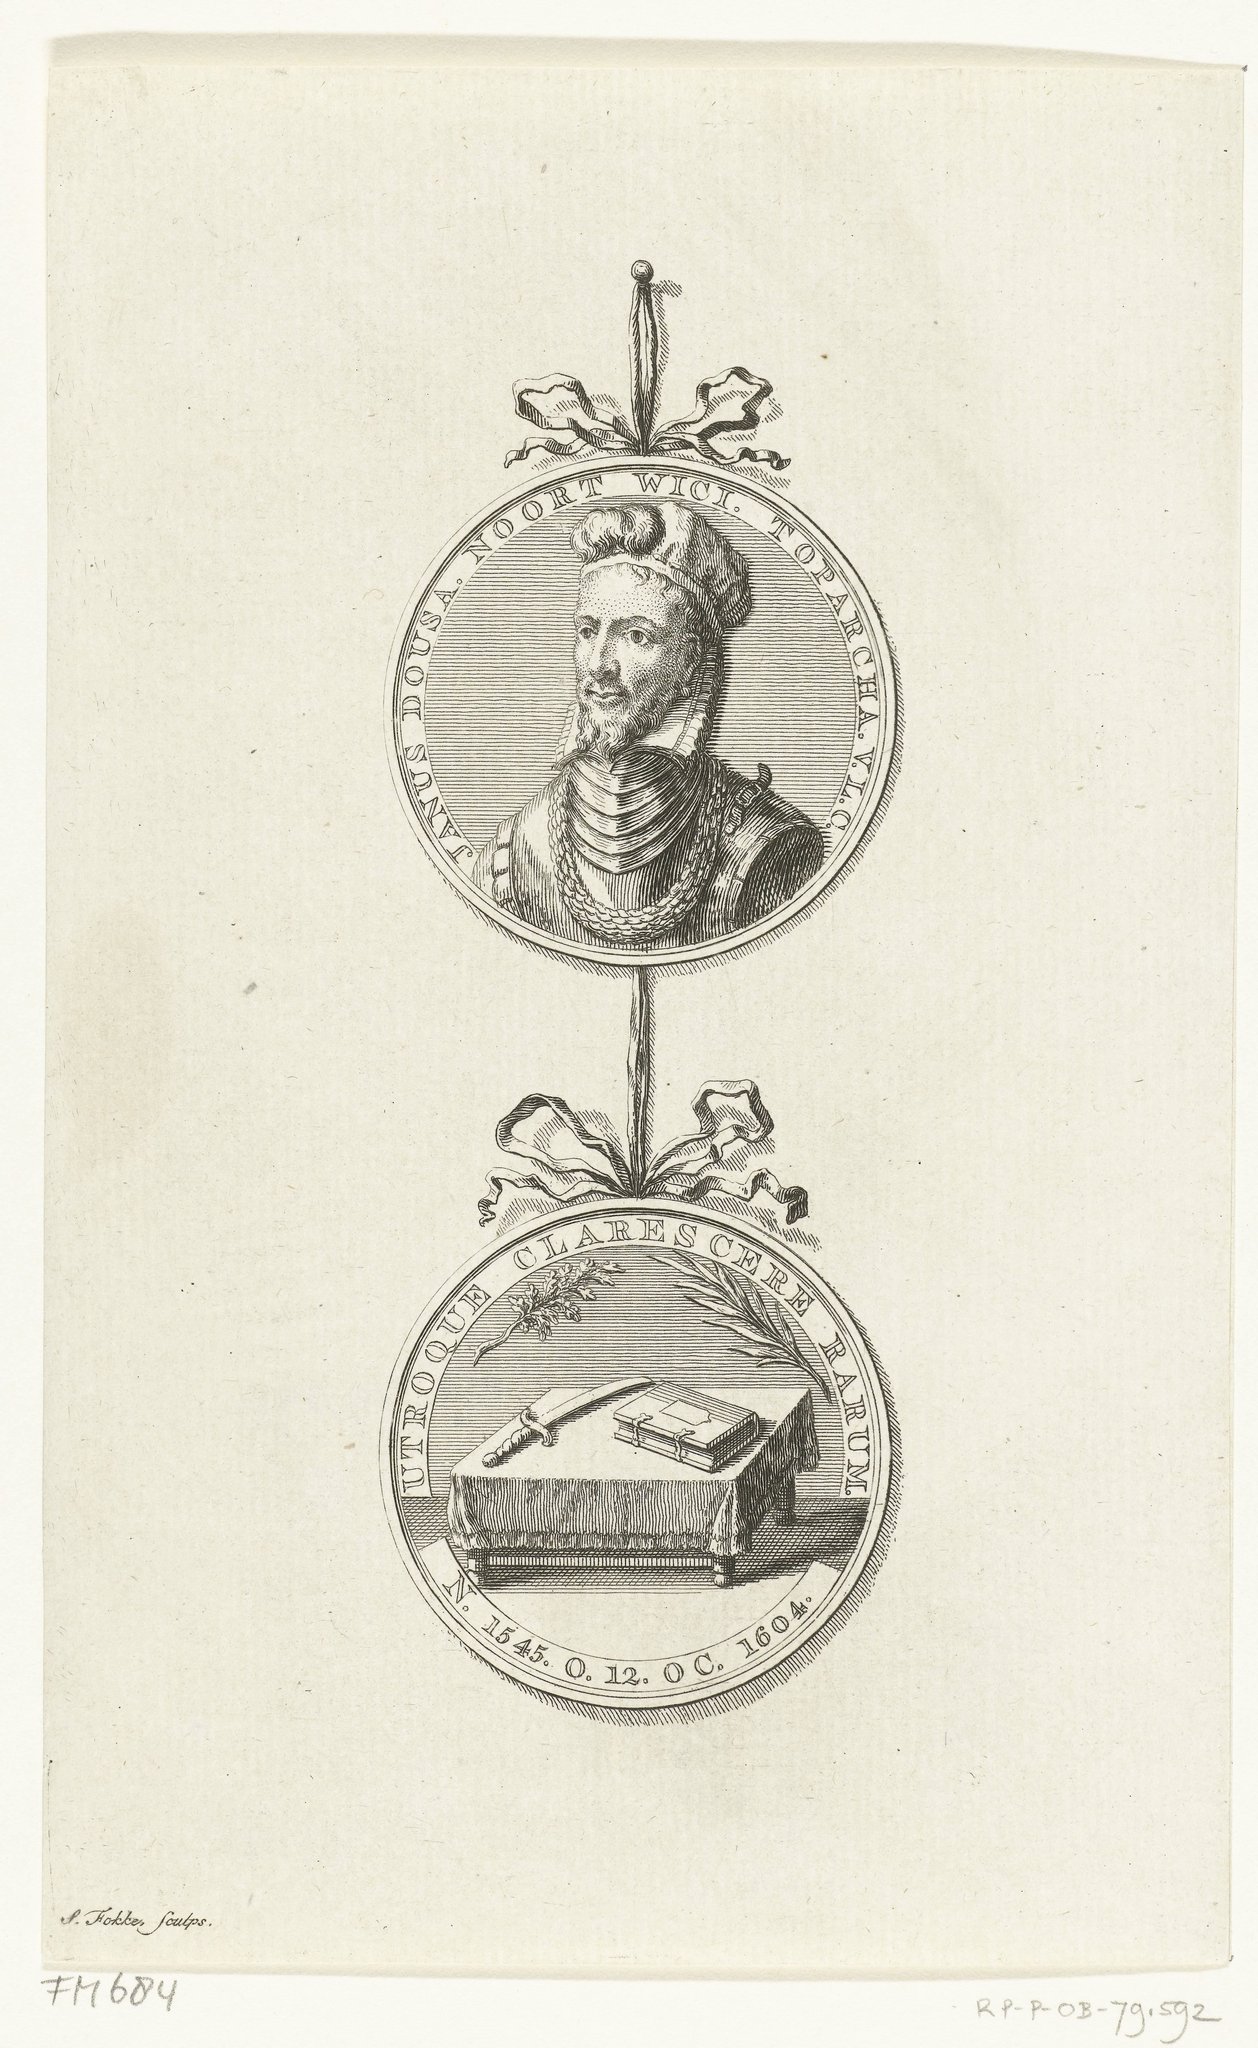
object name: print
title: Penning met portret van Johan van der Does, heer van Noordwijk, bevelhebber te Leiden tijdens het beleg, 1574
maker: simon fokke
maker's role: draughtsman, print maker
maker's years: 1712-1784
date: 1722-1784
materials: paper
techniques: etching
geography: netherlands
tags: medal (considered as a piece of sculpture, regardless of its specific function), leiden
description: Penning met portret van Johan van der Does, heer van Noordwijk, bevelhebber te Leiden tijdens het beleg, 1574. Bij zijn overlijden in 1604. Zilveren penning. Voorzijde: borststuk man binnen omschrift. Keerzijde: zwaard en boek liggend op een tafel onder een eiken- en een olijftak binnen omschrift. Voor- en keerzijde onder elkaar hangend aan lint.